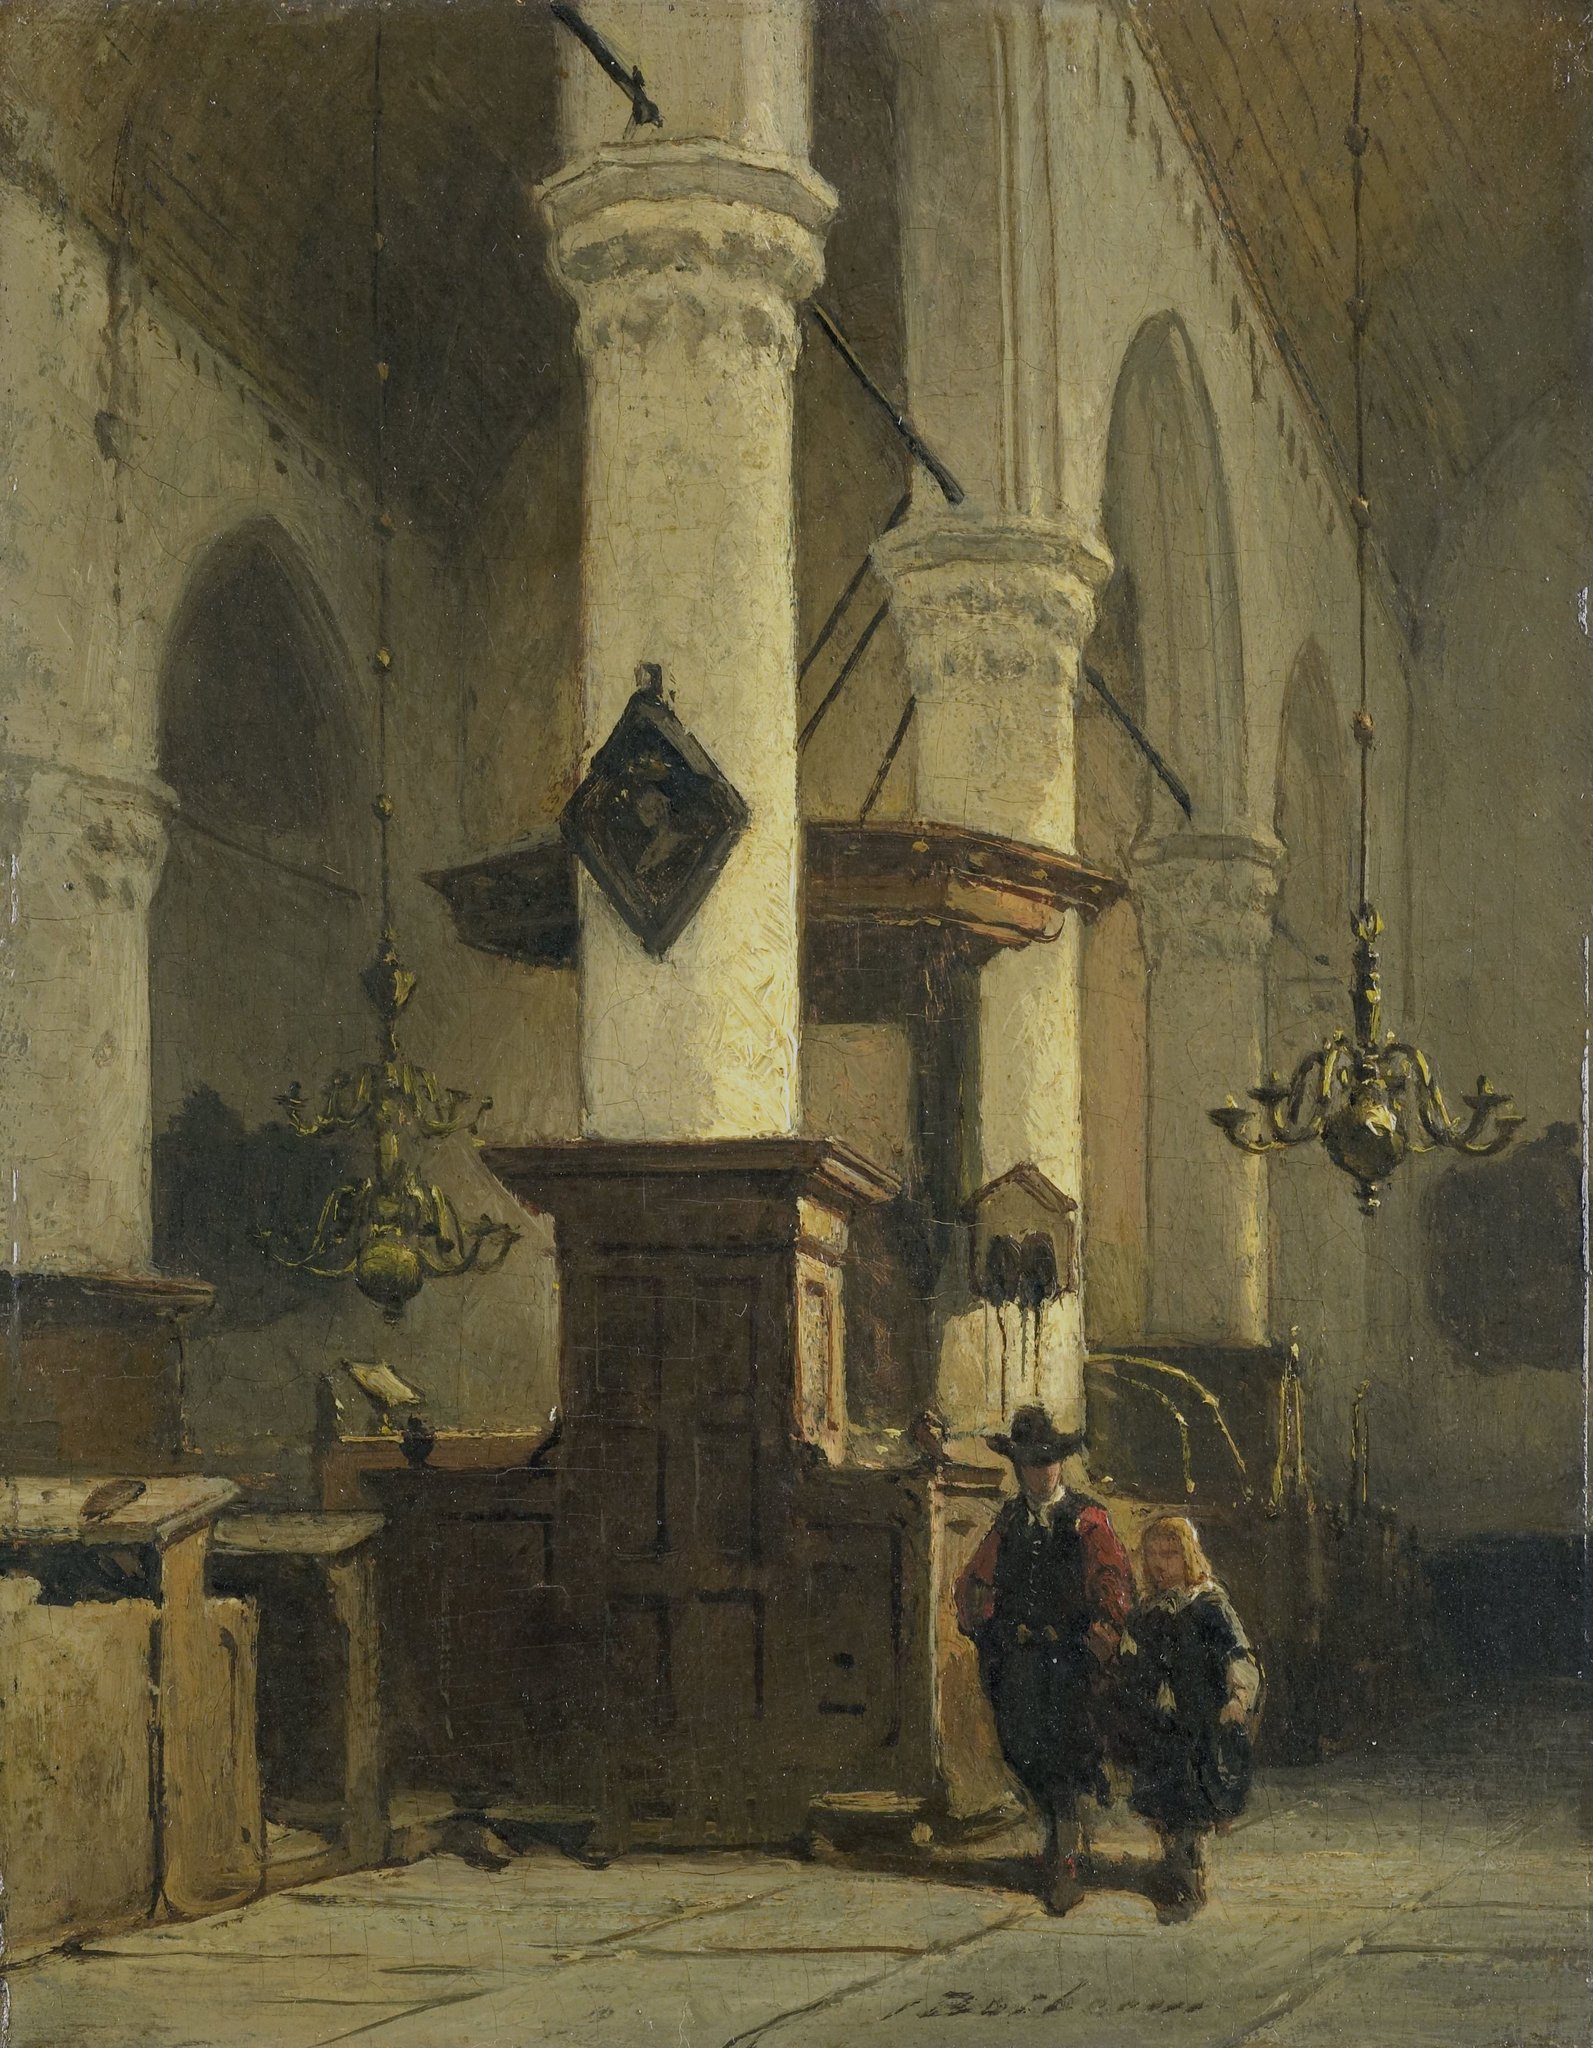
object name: painting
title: Church Interior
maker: johannes bosboom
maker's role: draughtsman, painter, print maker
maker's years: 1817-1891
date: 1850-1891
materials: oil, panel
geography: netherlands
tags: interior of church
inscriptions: inscription: ‘Kerk van een dorp tusschen Edam en Alkmaar.’, signature: ‘J. Bosboom’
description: Kerkinterieur. Een man en een jongen wandelen door het gangpad.